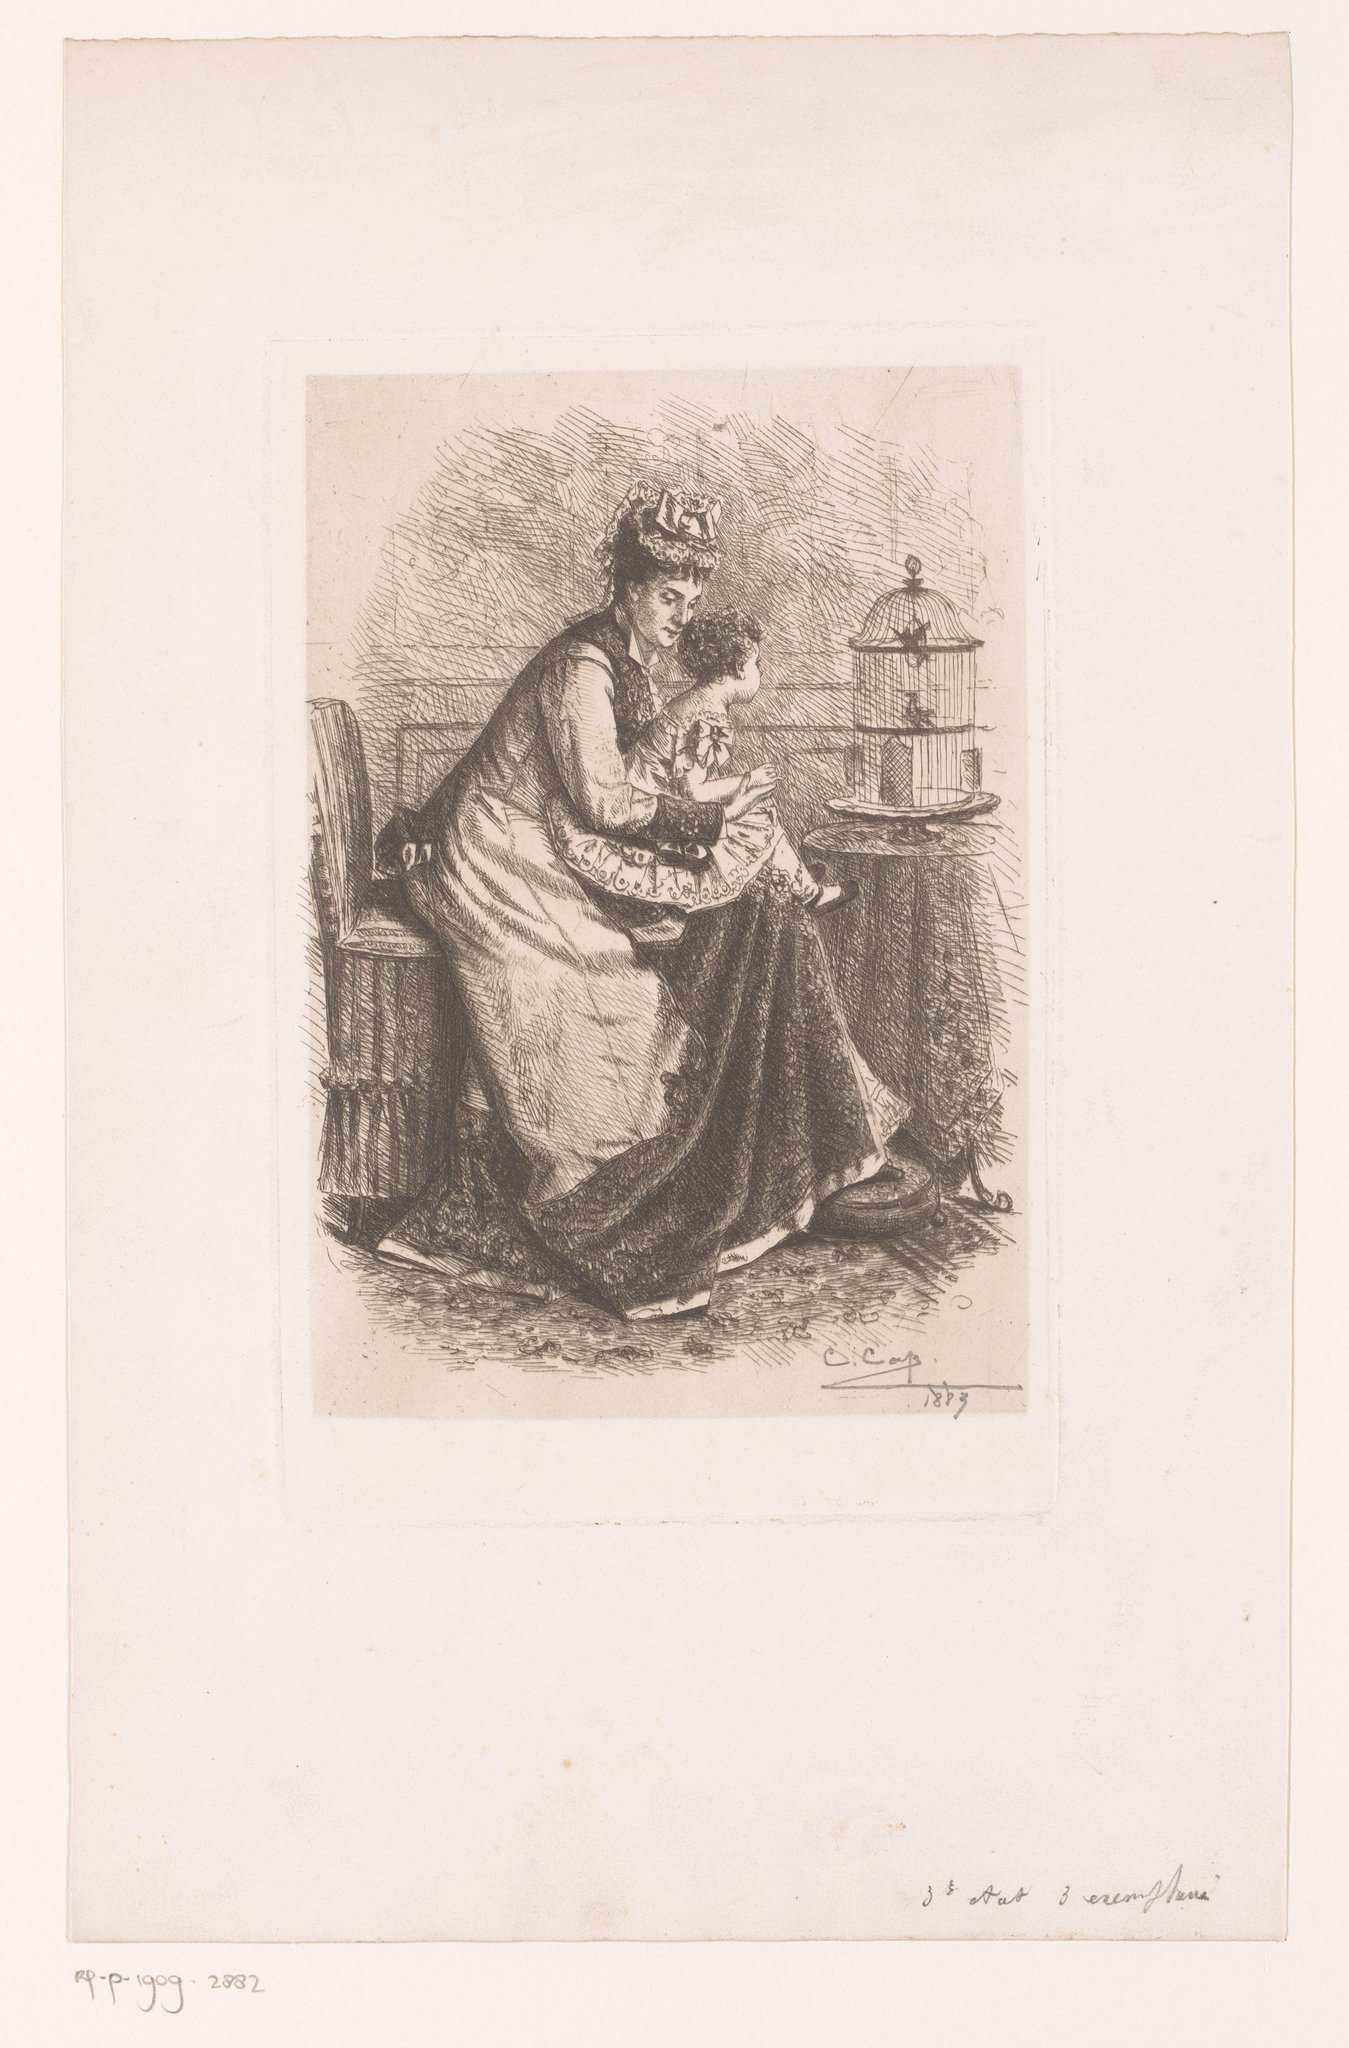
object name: print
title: Kind bij moeder op schoot kijkt naar de vogelkooi op tafel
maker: constant aimé marie cap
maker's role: print maker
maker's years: 1842-1915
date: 1883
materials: paper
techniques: drypoint, etching, intaglio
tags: mother and baby or young child, bird in a cage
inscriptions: collector's mark: Lugt 2228, annotation: ‘3e etat 3 exemplaires’